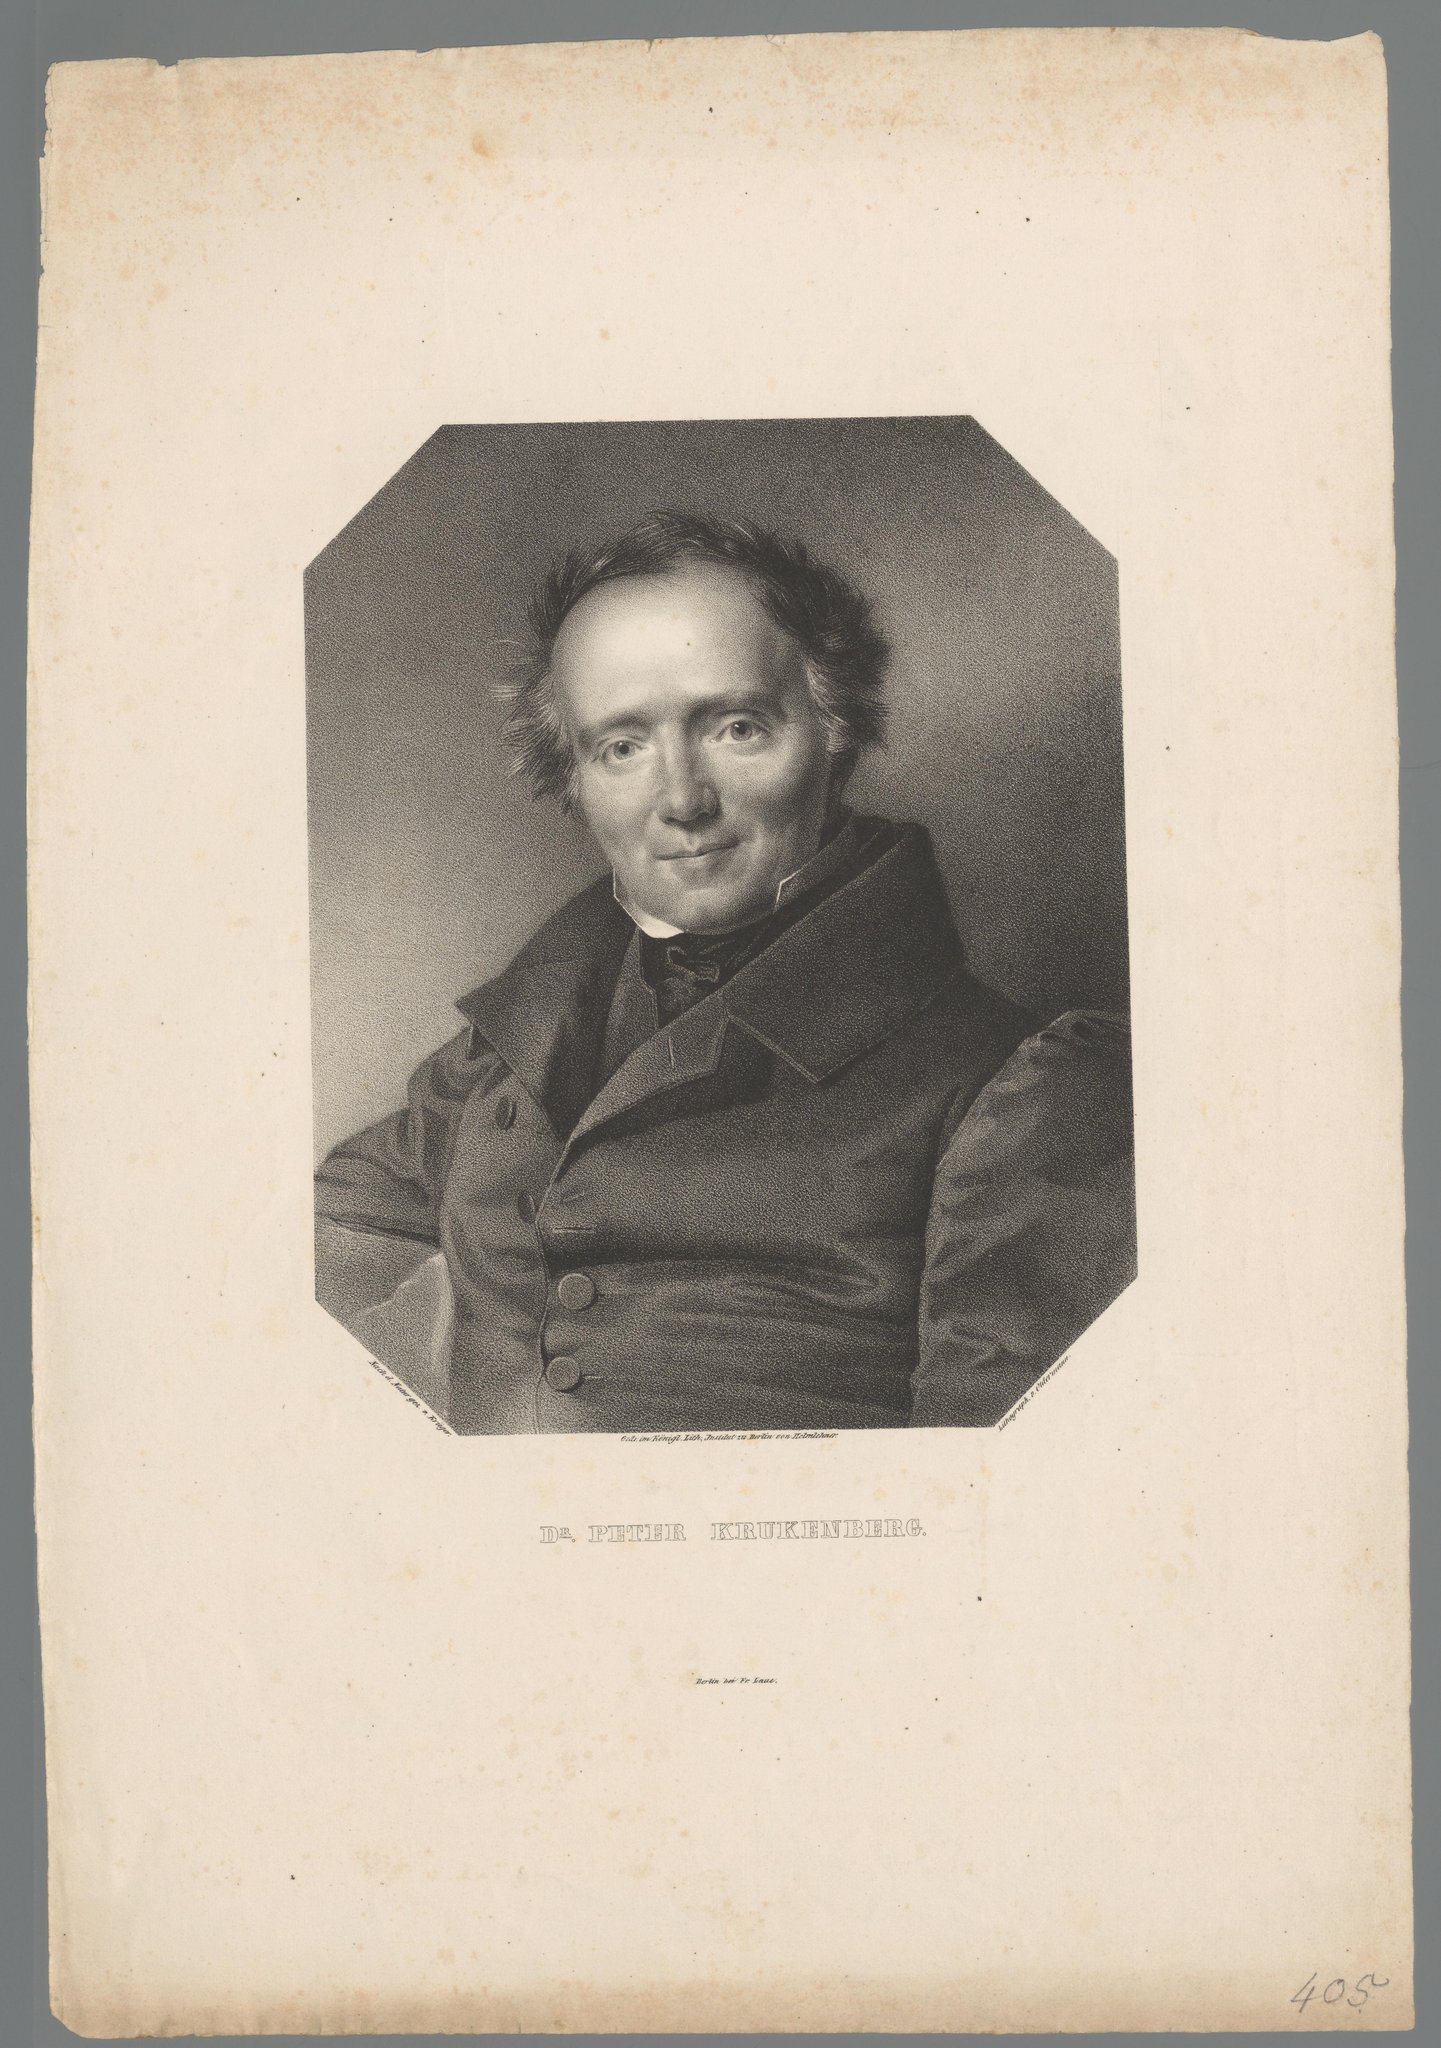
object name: print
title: Portret van Peter Krukenberg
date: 1812-1874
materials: paper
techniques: lithograph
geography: berlin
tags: adult man, historical persons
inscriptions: collector's mark: Lugt 2228